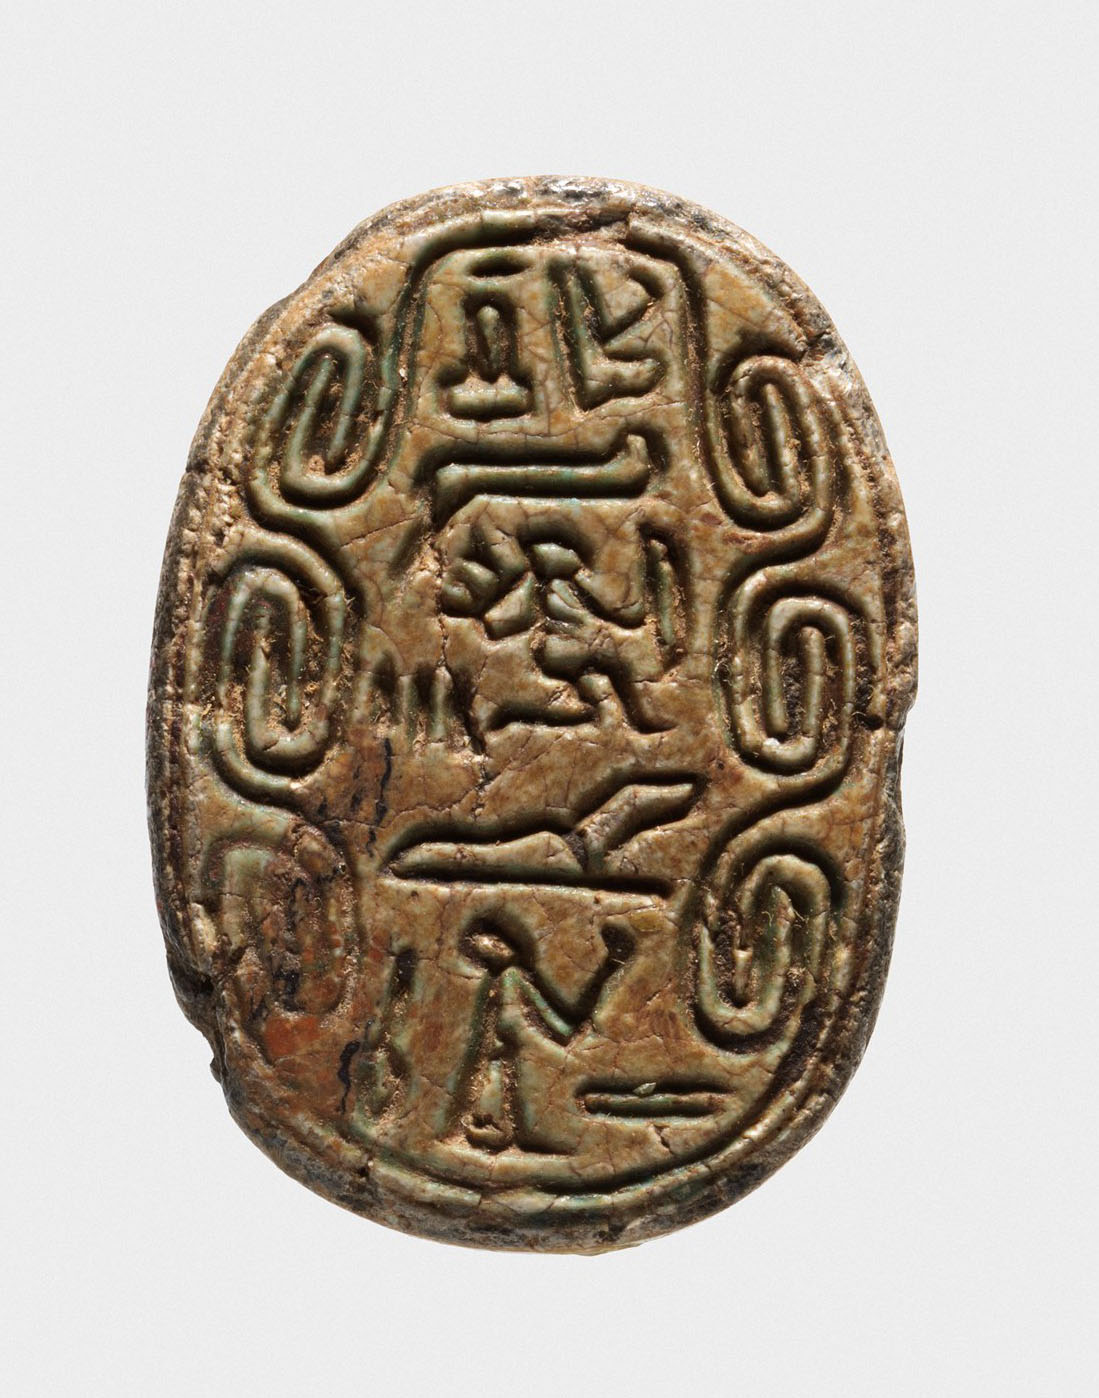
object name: scarab, sebeknakht, private name and title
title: Scarab of the Overseer of the Troops Sebeknakht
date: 1760-1670 BCE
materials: stone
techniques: glazing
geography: egypt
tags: hieroglyphs,scarabs